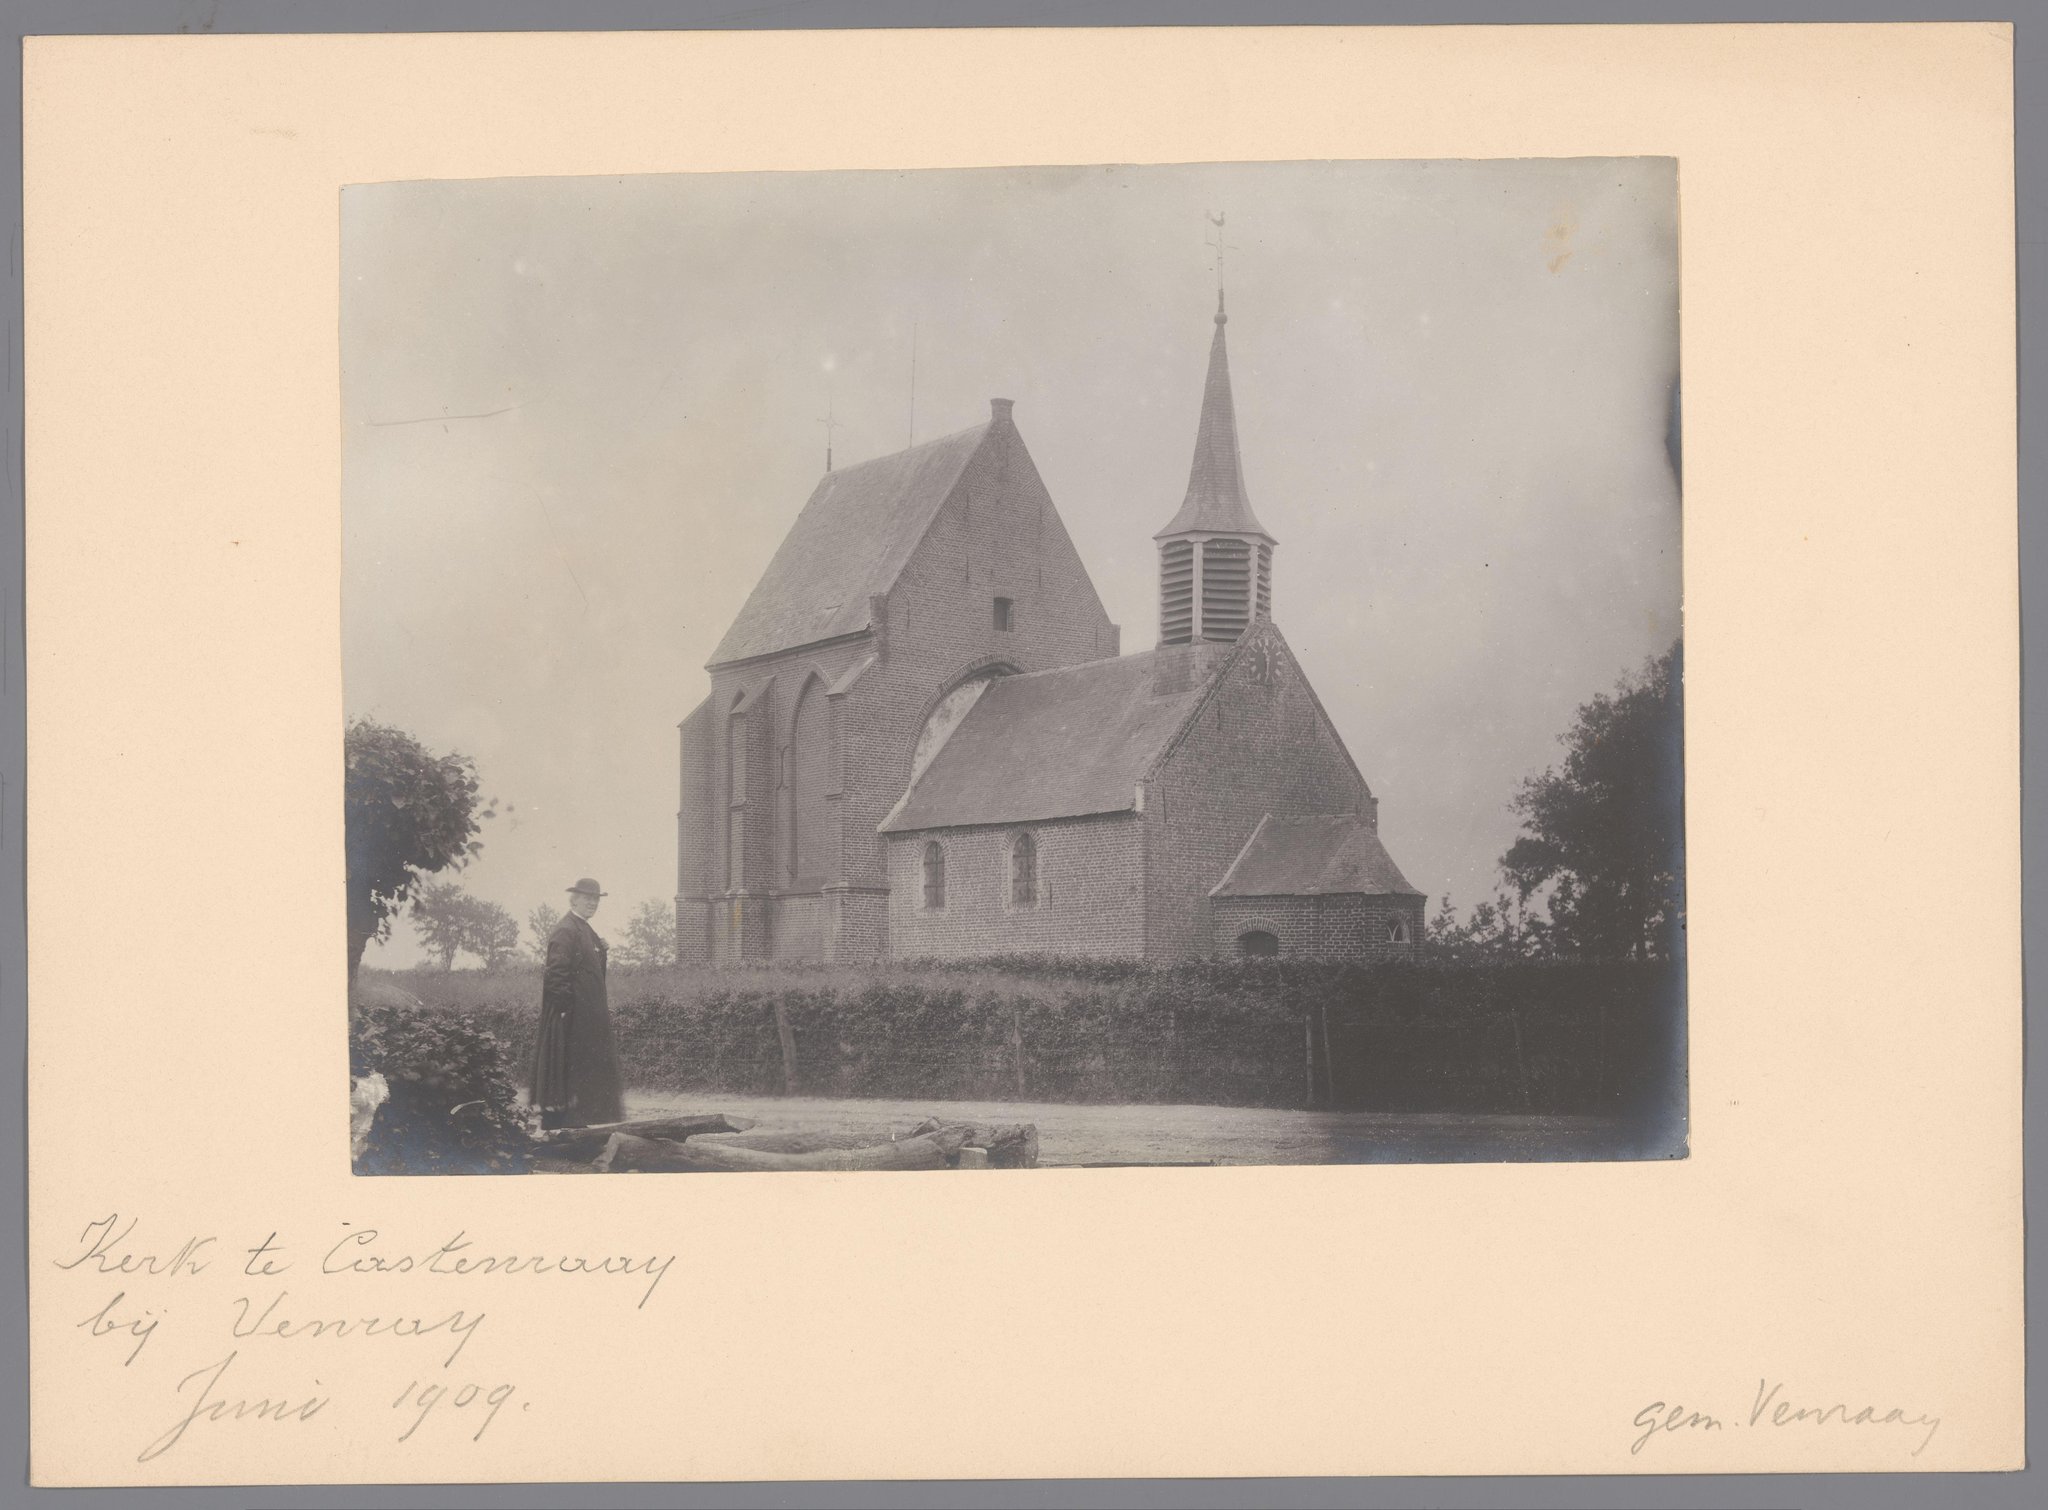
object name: photograph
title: Gezicht op een kerk te Castenray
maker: anoniem (monumentenzorg)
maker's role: fotograaf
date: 1909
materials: cardboard, photographic support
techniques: gelatin silver print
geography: castenray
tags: church (exterior)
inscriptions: annotation: ‘Kerk te Castenray bij Venray/ juni 1909/ gem. Venraay’, annotation: ‘Venlo (L.)/ gedeelte walmuur/ juni 1905’